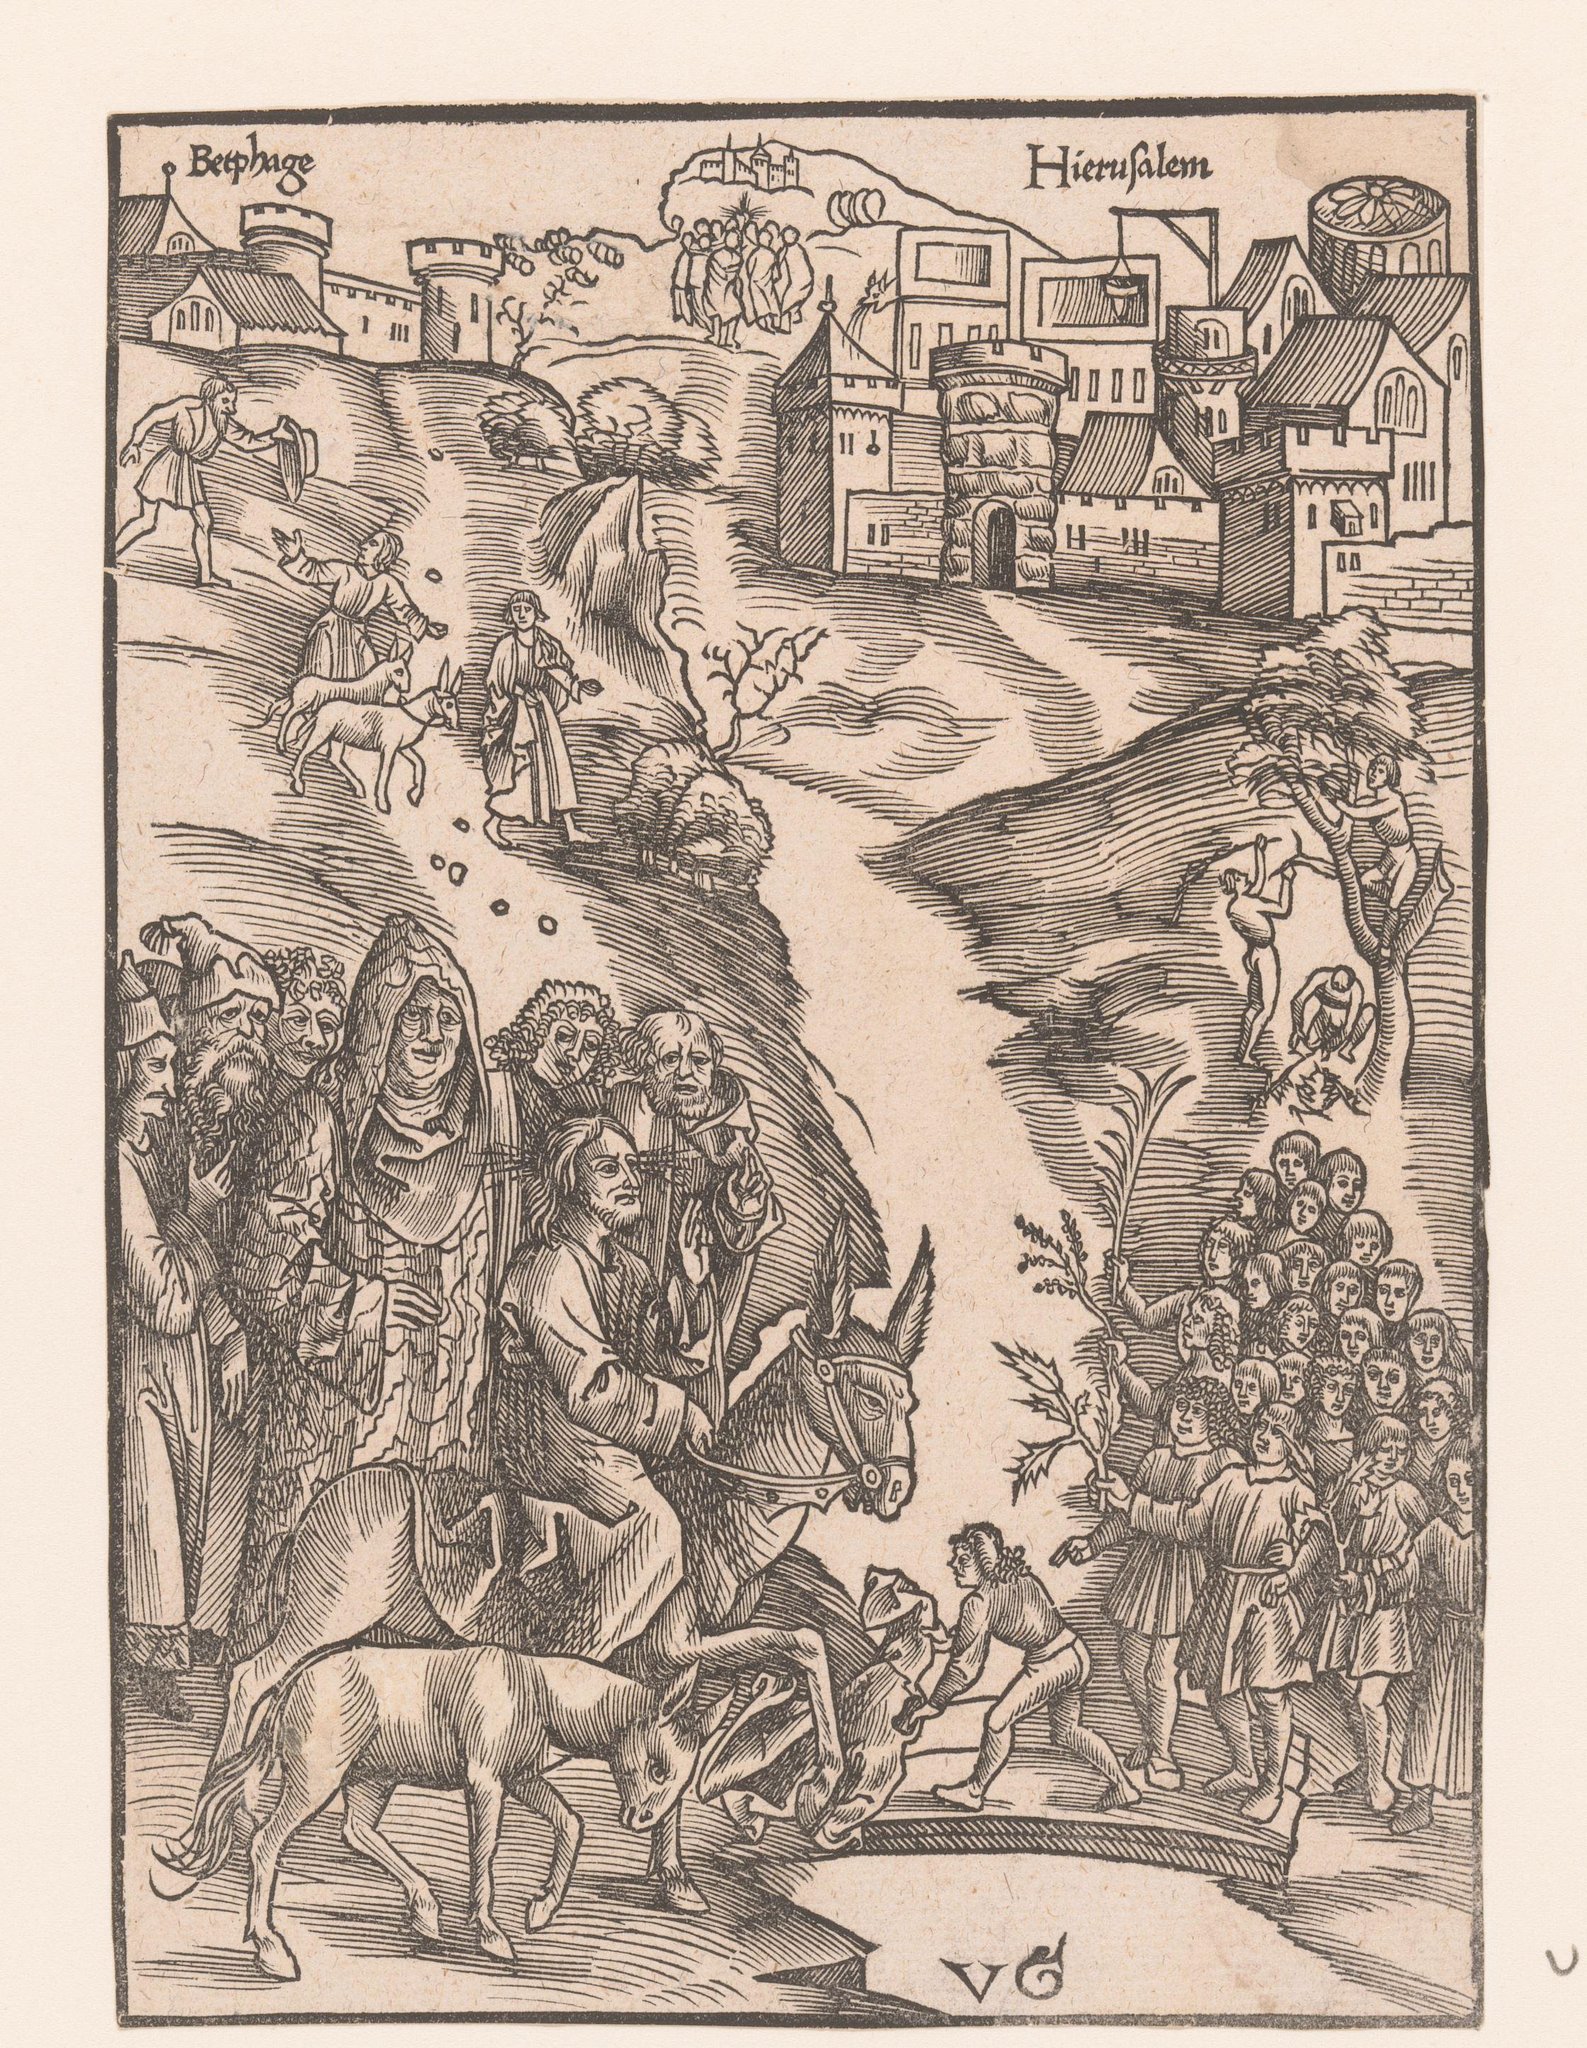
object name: print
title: Intocht van Christus in Jerzalem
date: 1506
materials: paper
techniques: woodcut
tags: entry into jerusalem: people spreading their clothes before christ on the ass, and waving palm branches (matthew 21:1-11, 21:14-16; mark 11:1-11; luke 19:28-40; john 12:12-19)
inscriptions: collector's mark: Lugt 240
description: Afkomstig uit: Der Text des Passions oder Lidens Christi (...). Straatsburg: N. Ringmann, 1506.